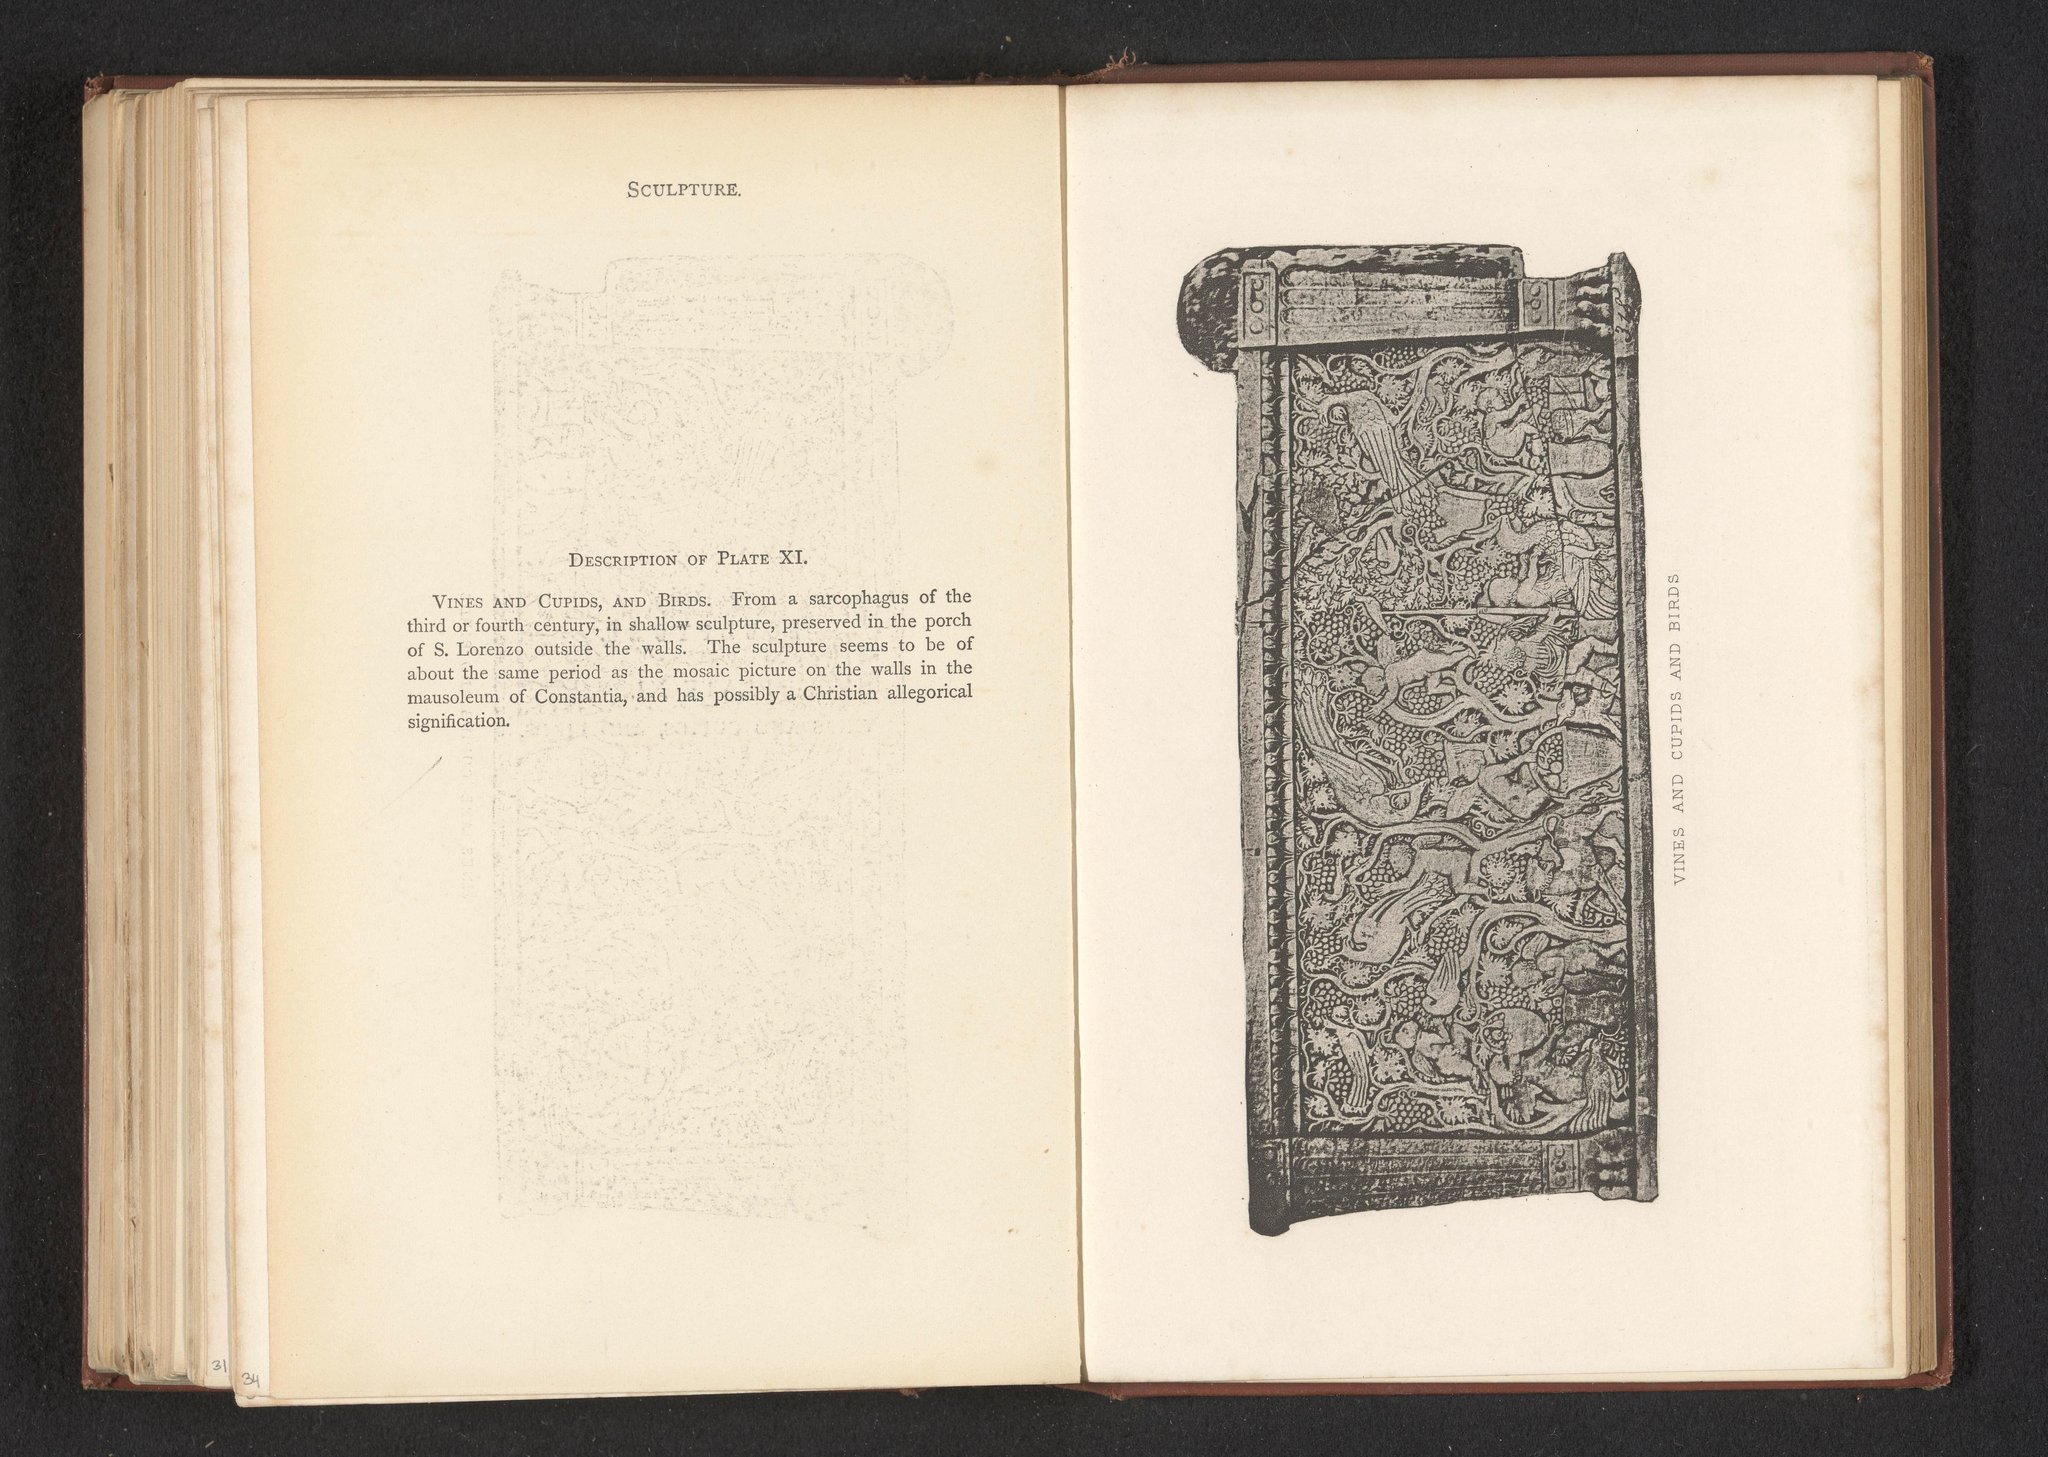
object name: page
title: Vines and cupids and birds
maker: Anonymous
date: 1867-1877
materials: paper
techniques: photoaquatint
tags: vine, sarcophagus, decorating 'en relief', appliquéing, cupids: 'amores', 'amoretti', 'putti'